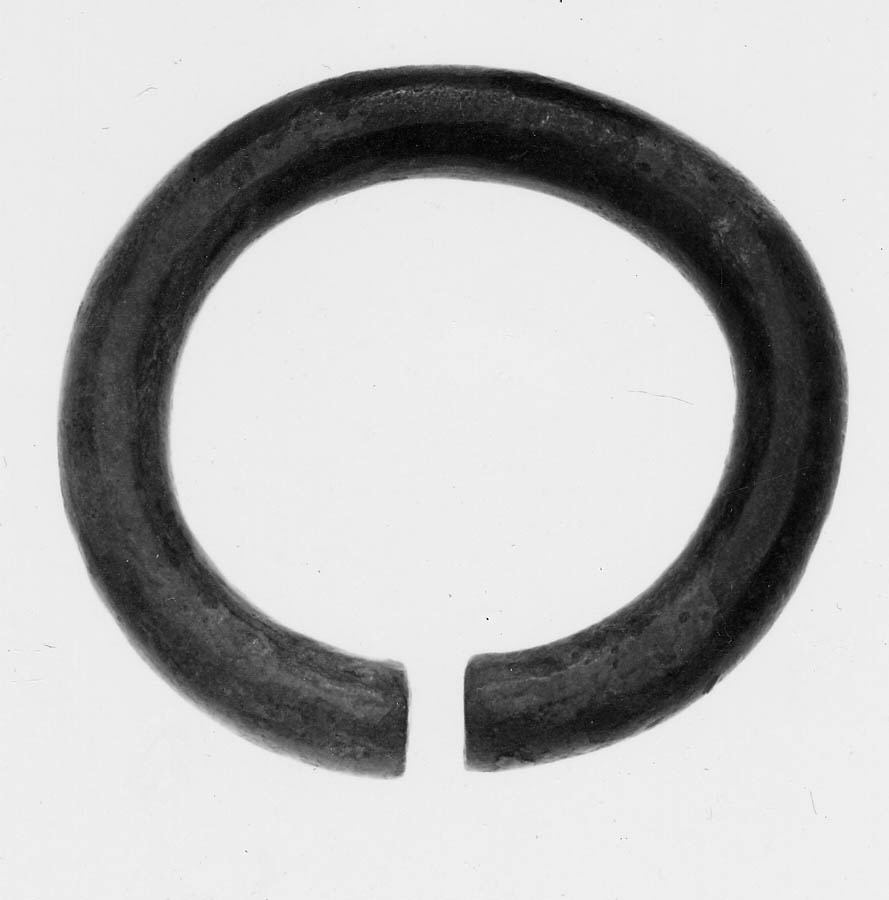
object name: bangle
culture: indian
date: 1500-500 BCE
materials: copper